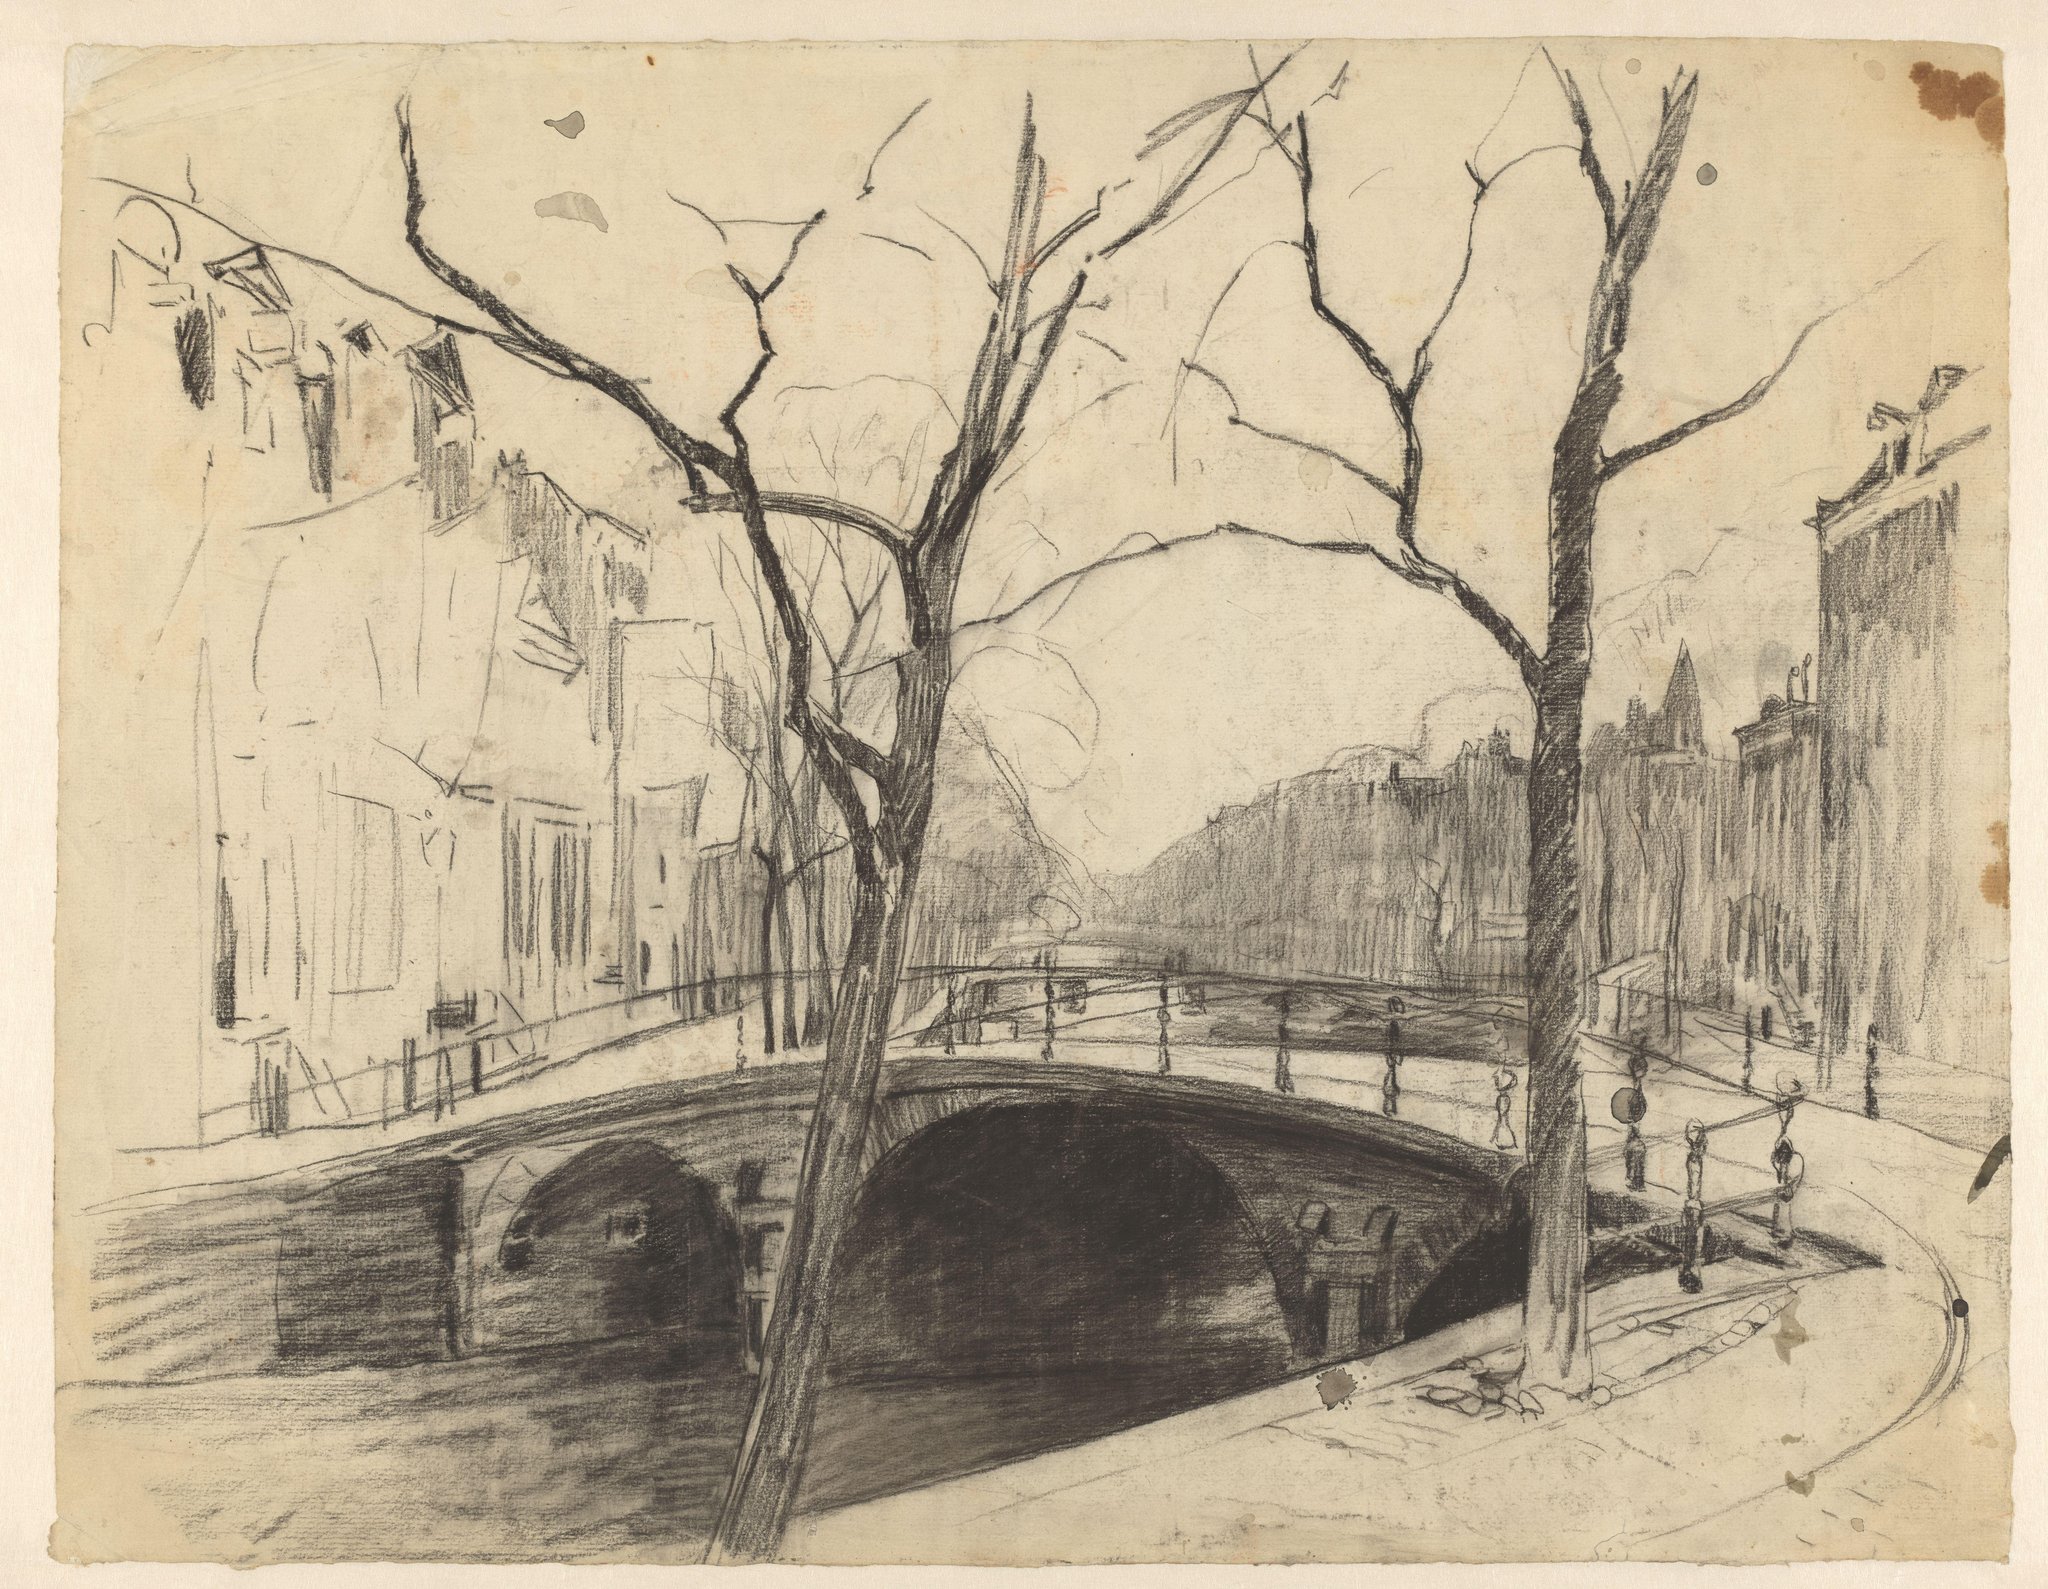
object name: drawing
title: Gezicht over een gracht te Amsterdam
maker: willem witsen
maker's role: draughtsman, painter, print maker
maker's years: 1860-1923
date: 1870-1923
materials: chalk, paper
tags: trees, canals, waters (in city), amsterdam